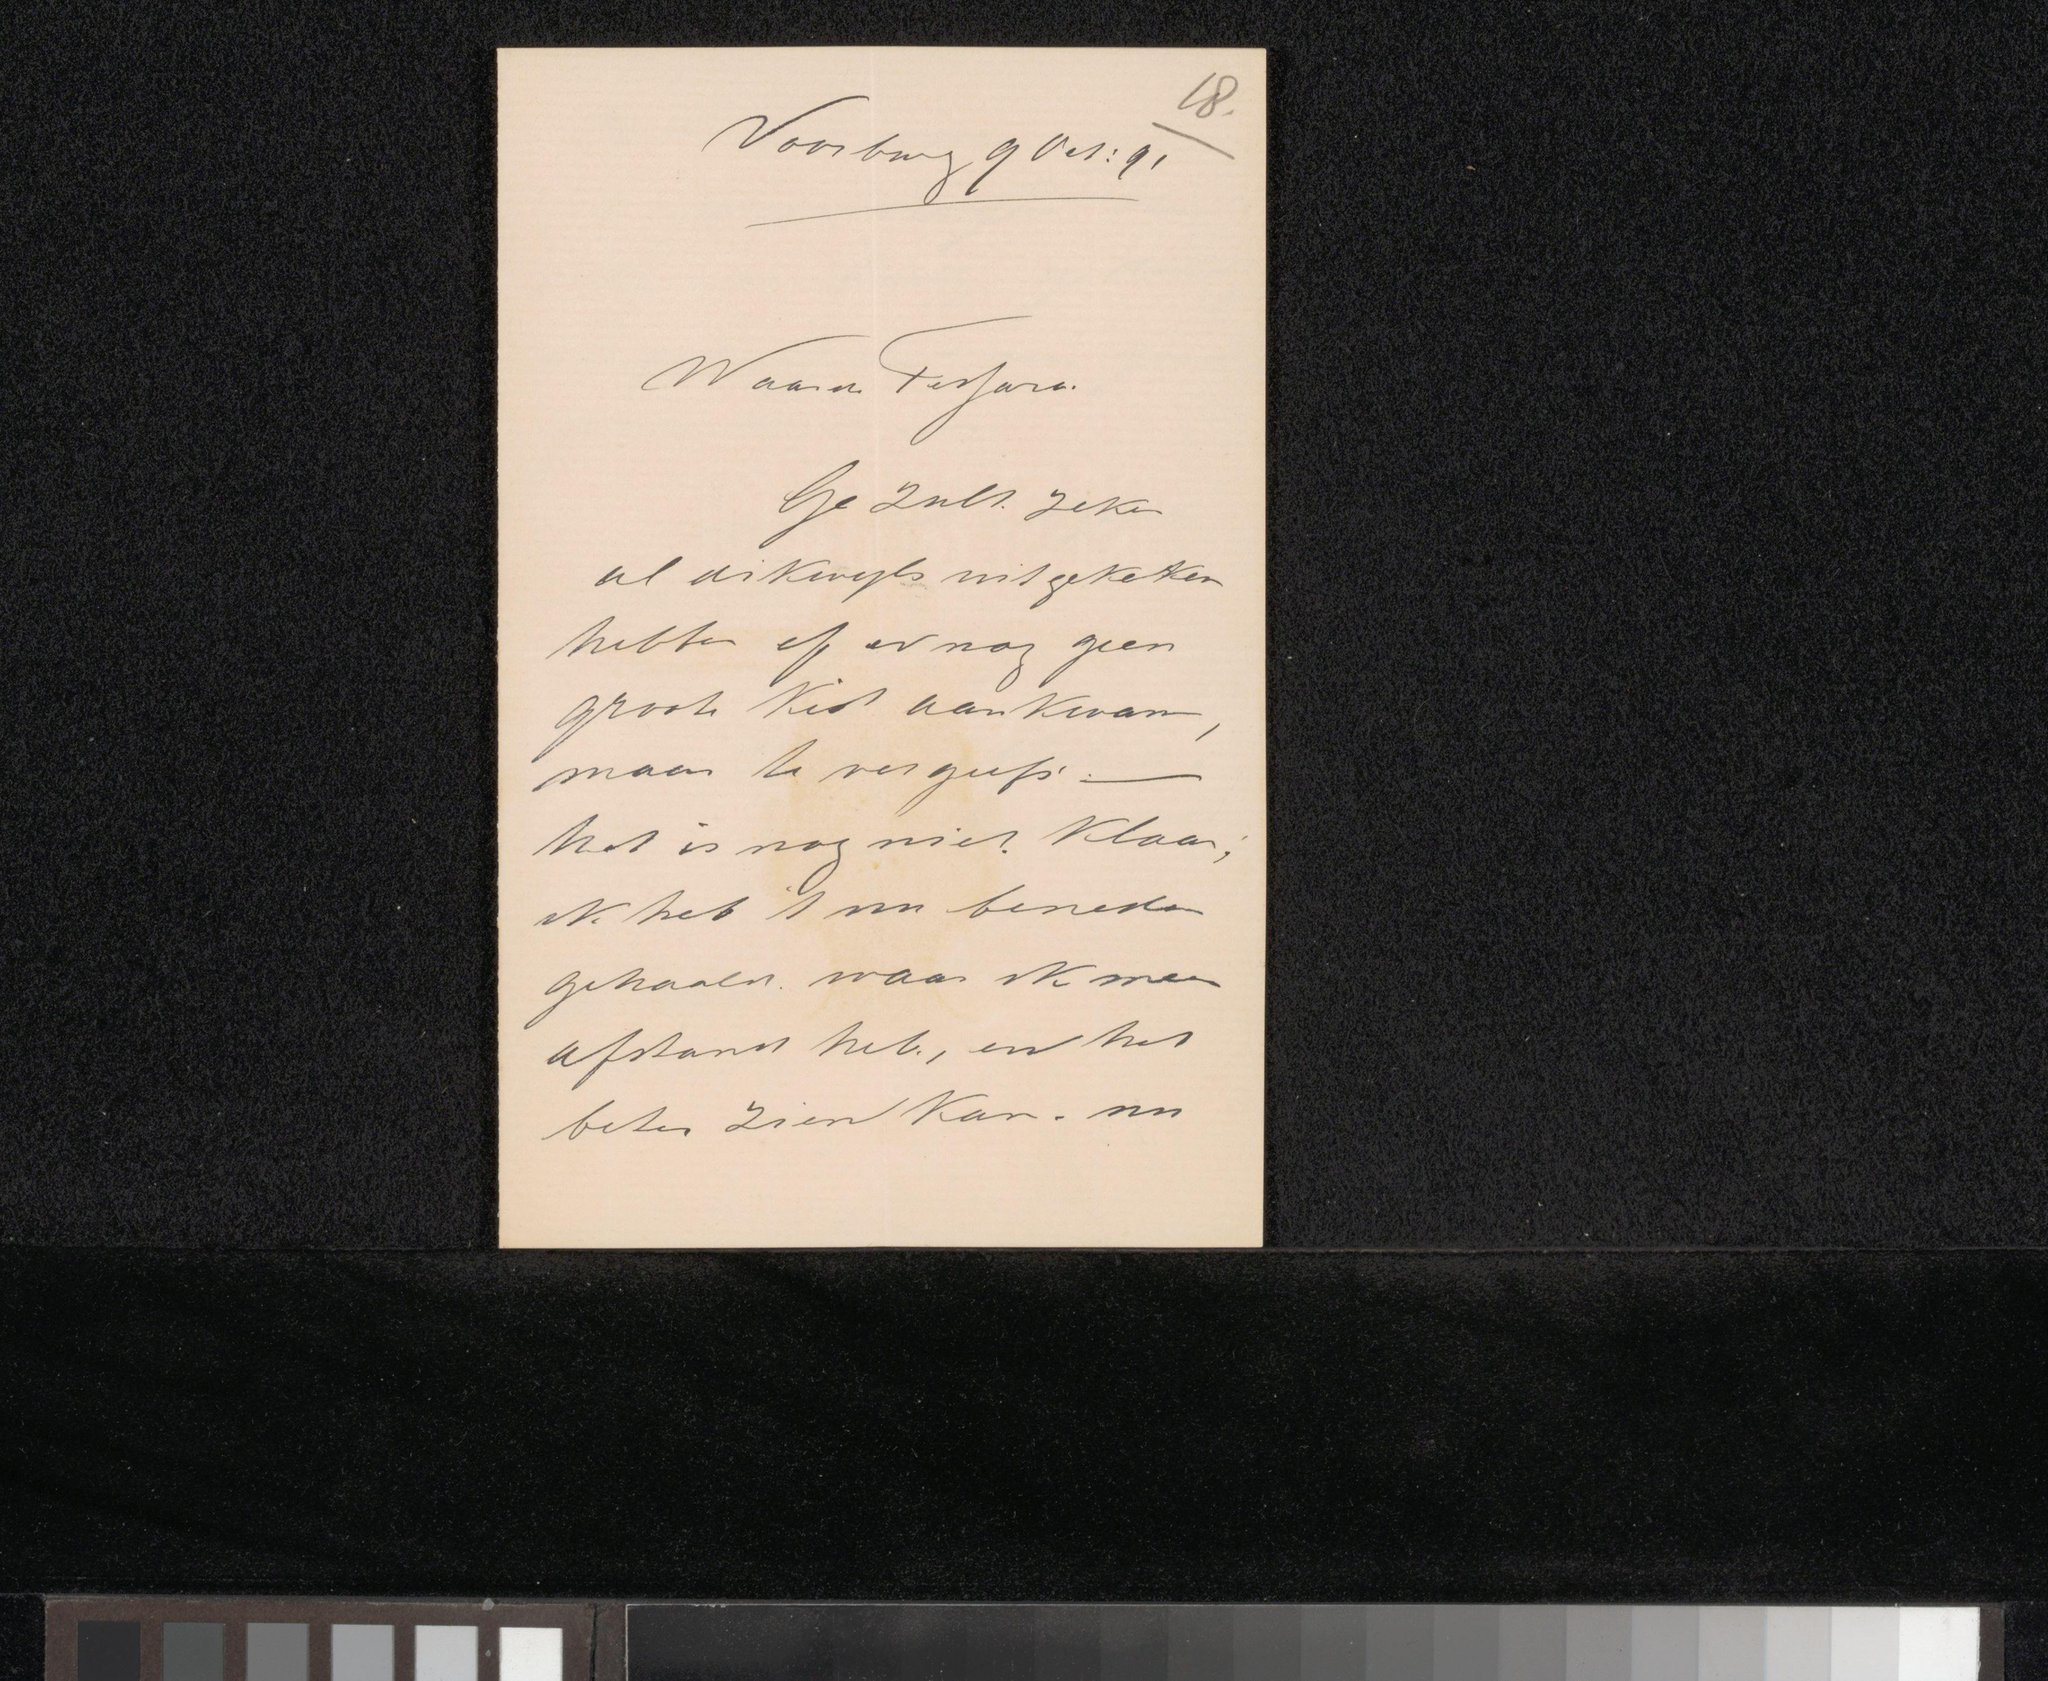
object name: letter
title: Brief aan Filippo Tessaro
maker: willem maris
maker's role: draughtsman, painter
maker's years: 1844-1910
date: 1891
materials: ink, paper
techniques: pen, writing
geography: voorburg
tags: amsterdam, art trade, art shop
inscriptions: collector's mark: Lugt 2228, watermark, collector's mark: Lugt 2233